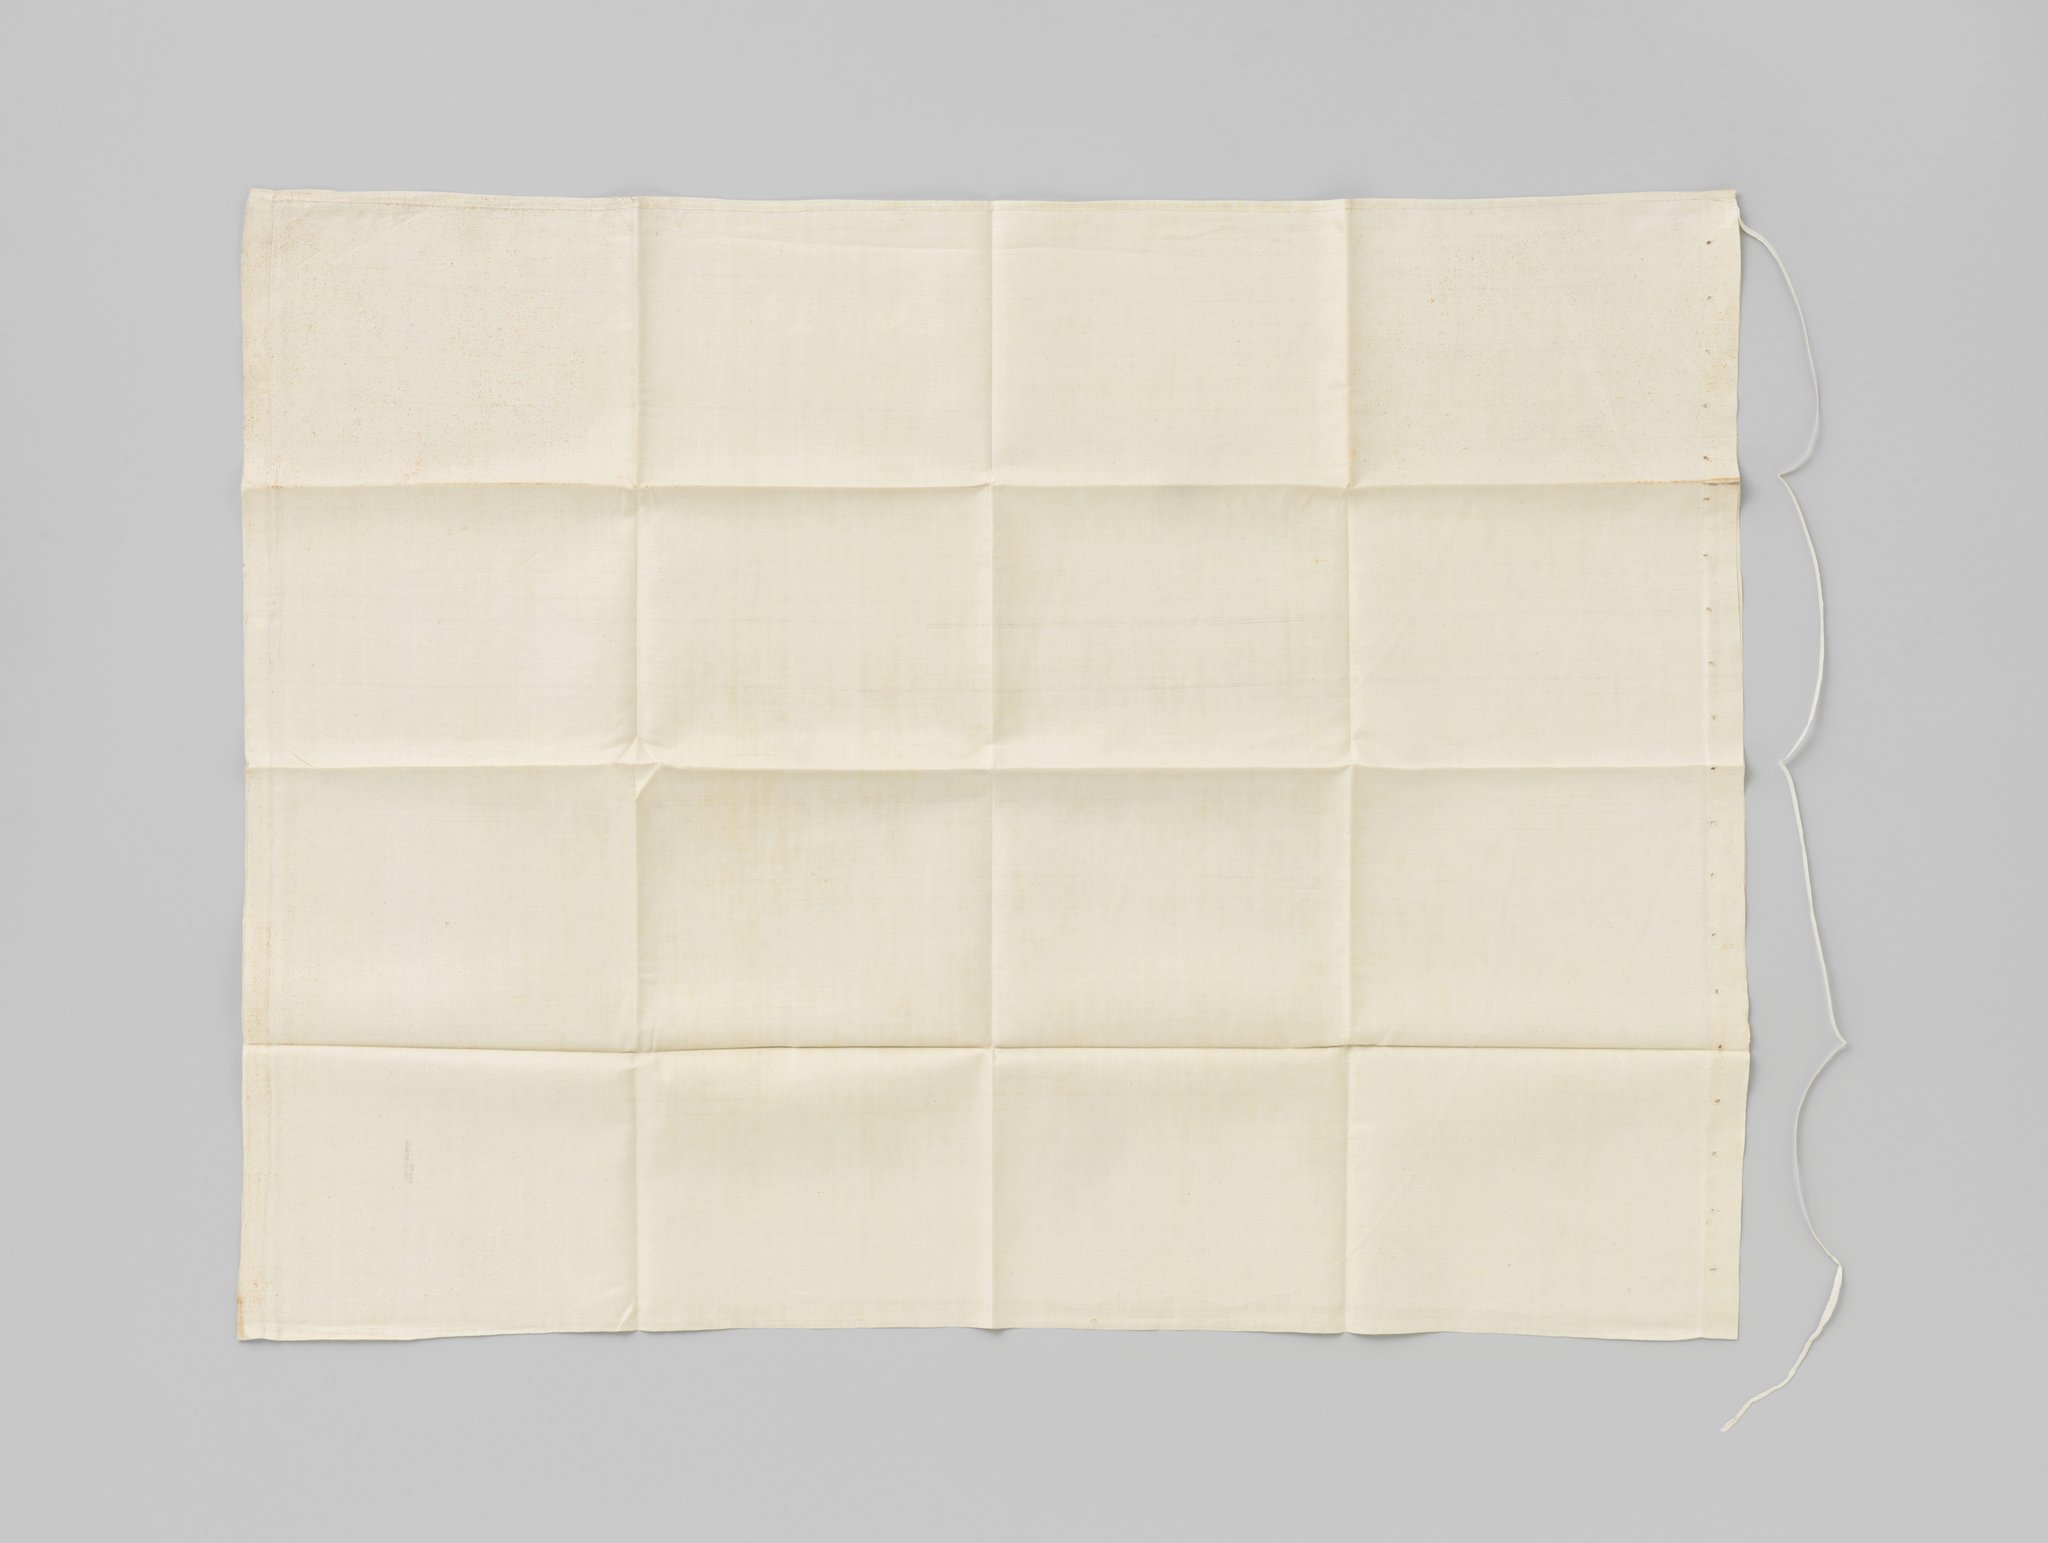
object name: pillowcase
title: Kussensloop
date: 1831-1875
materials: linen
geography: northern netherlands